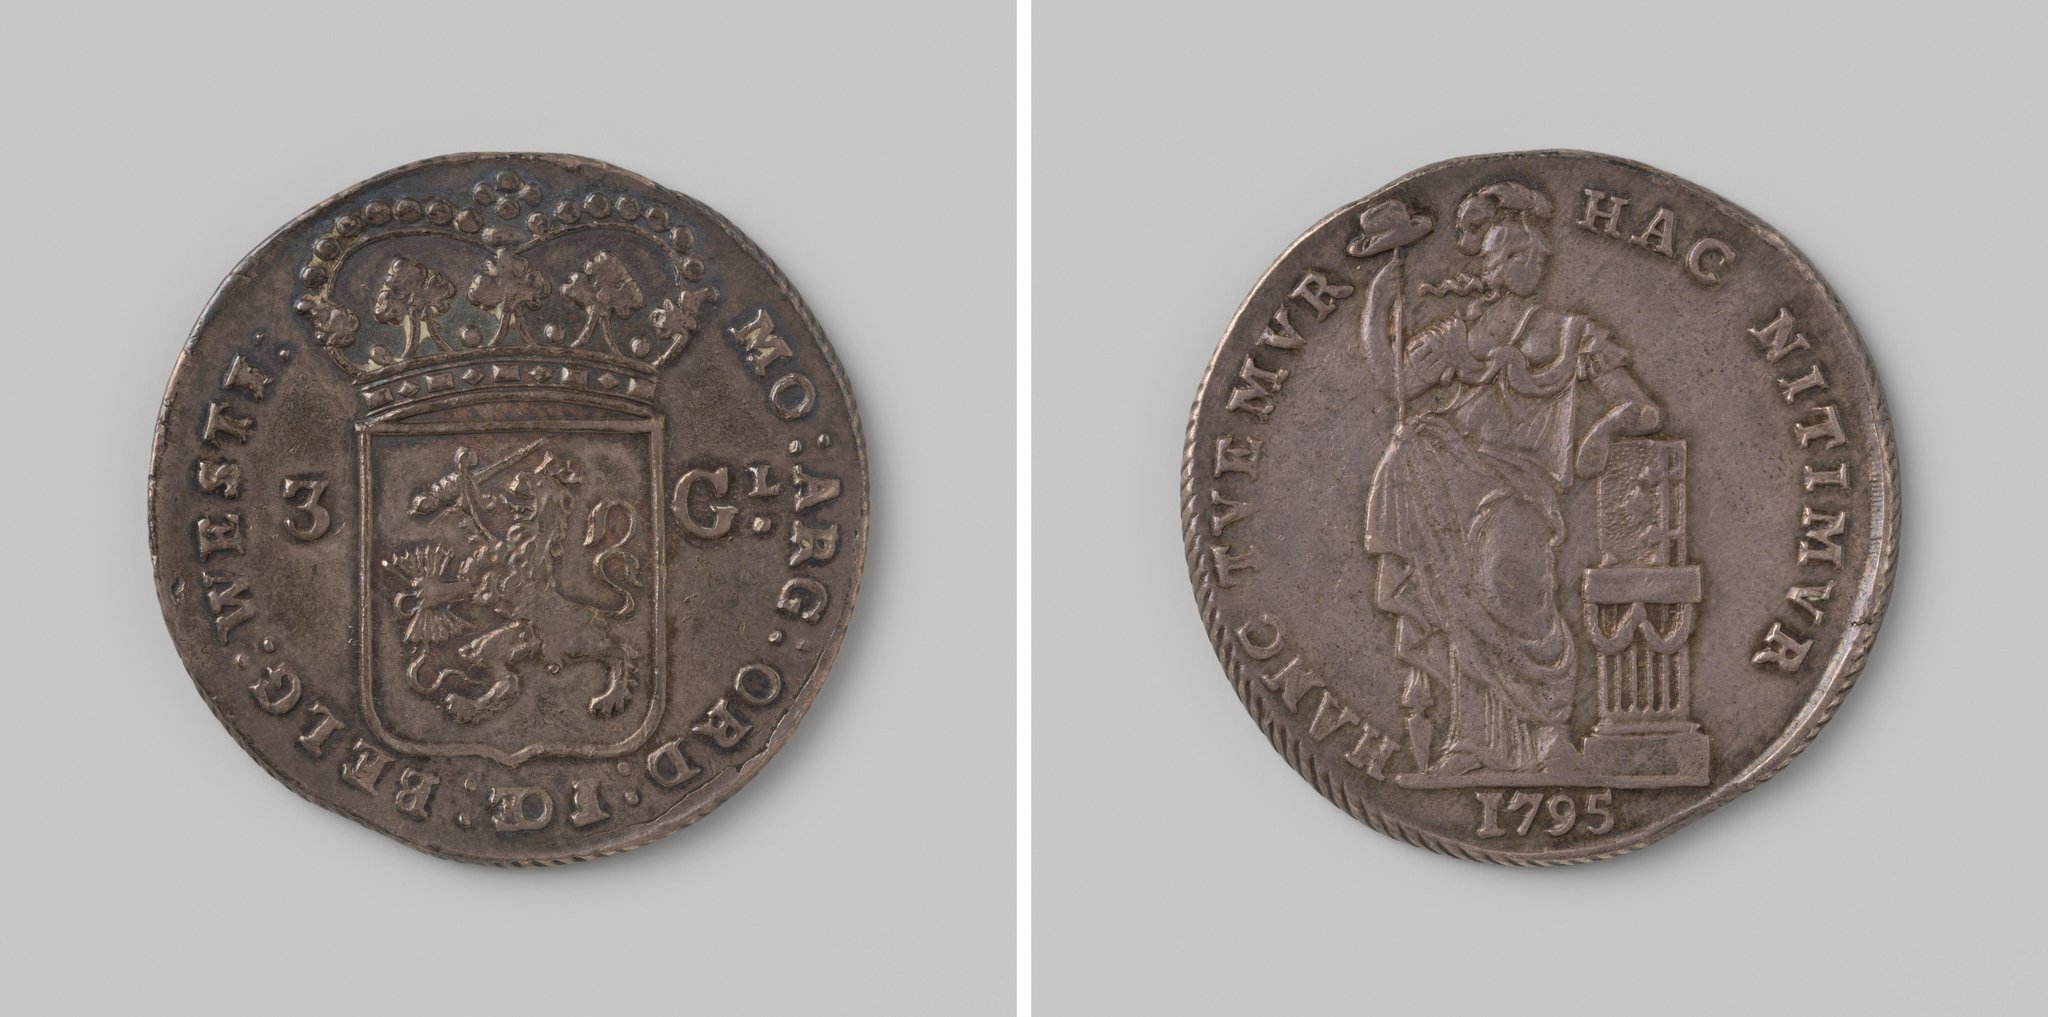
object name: coin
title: Bataafse Republiek, drie gulden op naam van West-Friesland, 1795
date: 1795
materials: silver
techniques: striking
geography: west frisia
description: Zilveren munt. Voorzijde: tussen waarde-aanduiding gekroond generaliteirtswapenschild. Omschrift eindigend in: WESTF. Keerzijde: Nederlandse maagd met vrijheidshoed en speer, leunend op een bijbel op een altaar. In afsnede jaartal. Kabelrand.